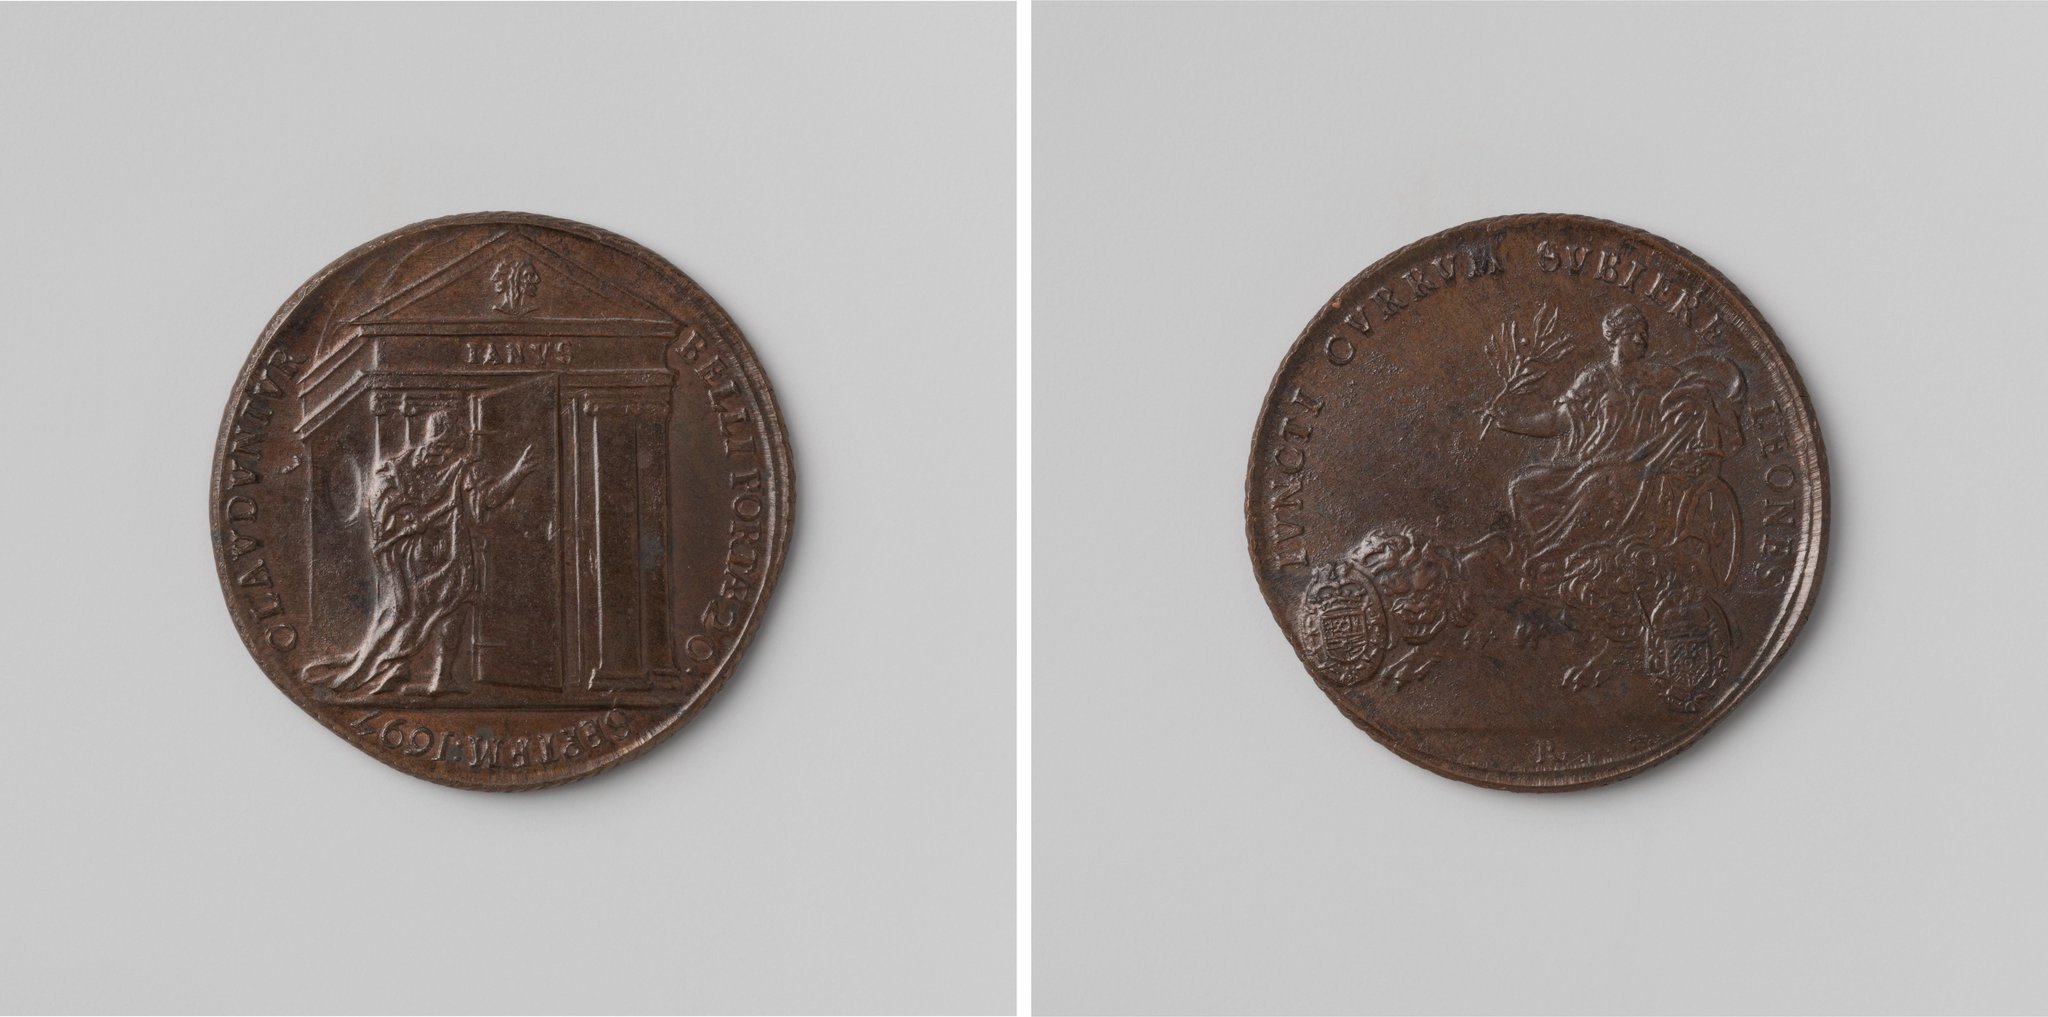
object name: jeton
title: Vrede van Rijswijk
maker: philippe roëttiers (ii)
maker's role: medailleur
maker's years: 1640-1718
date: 1697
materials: copper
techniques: striking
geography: antwerp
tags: maximiliaan ii emanuel (keurvorst van beieren)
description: Koperen penning. Voorzijde: keurvorst van Beieren, in Romeinse kledij staande naast de door hem gesloten tempel van Janus binnen omschrift. Keerzijde: Vrede met olijftak in hand, zittend op zegekar die wordt getrokken door twee leeuwen, die elk klauw op een wapenschild leggen binnen omschrift; afsnede: signatuur